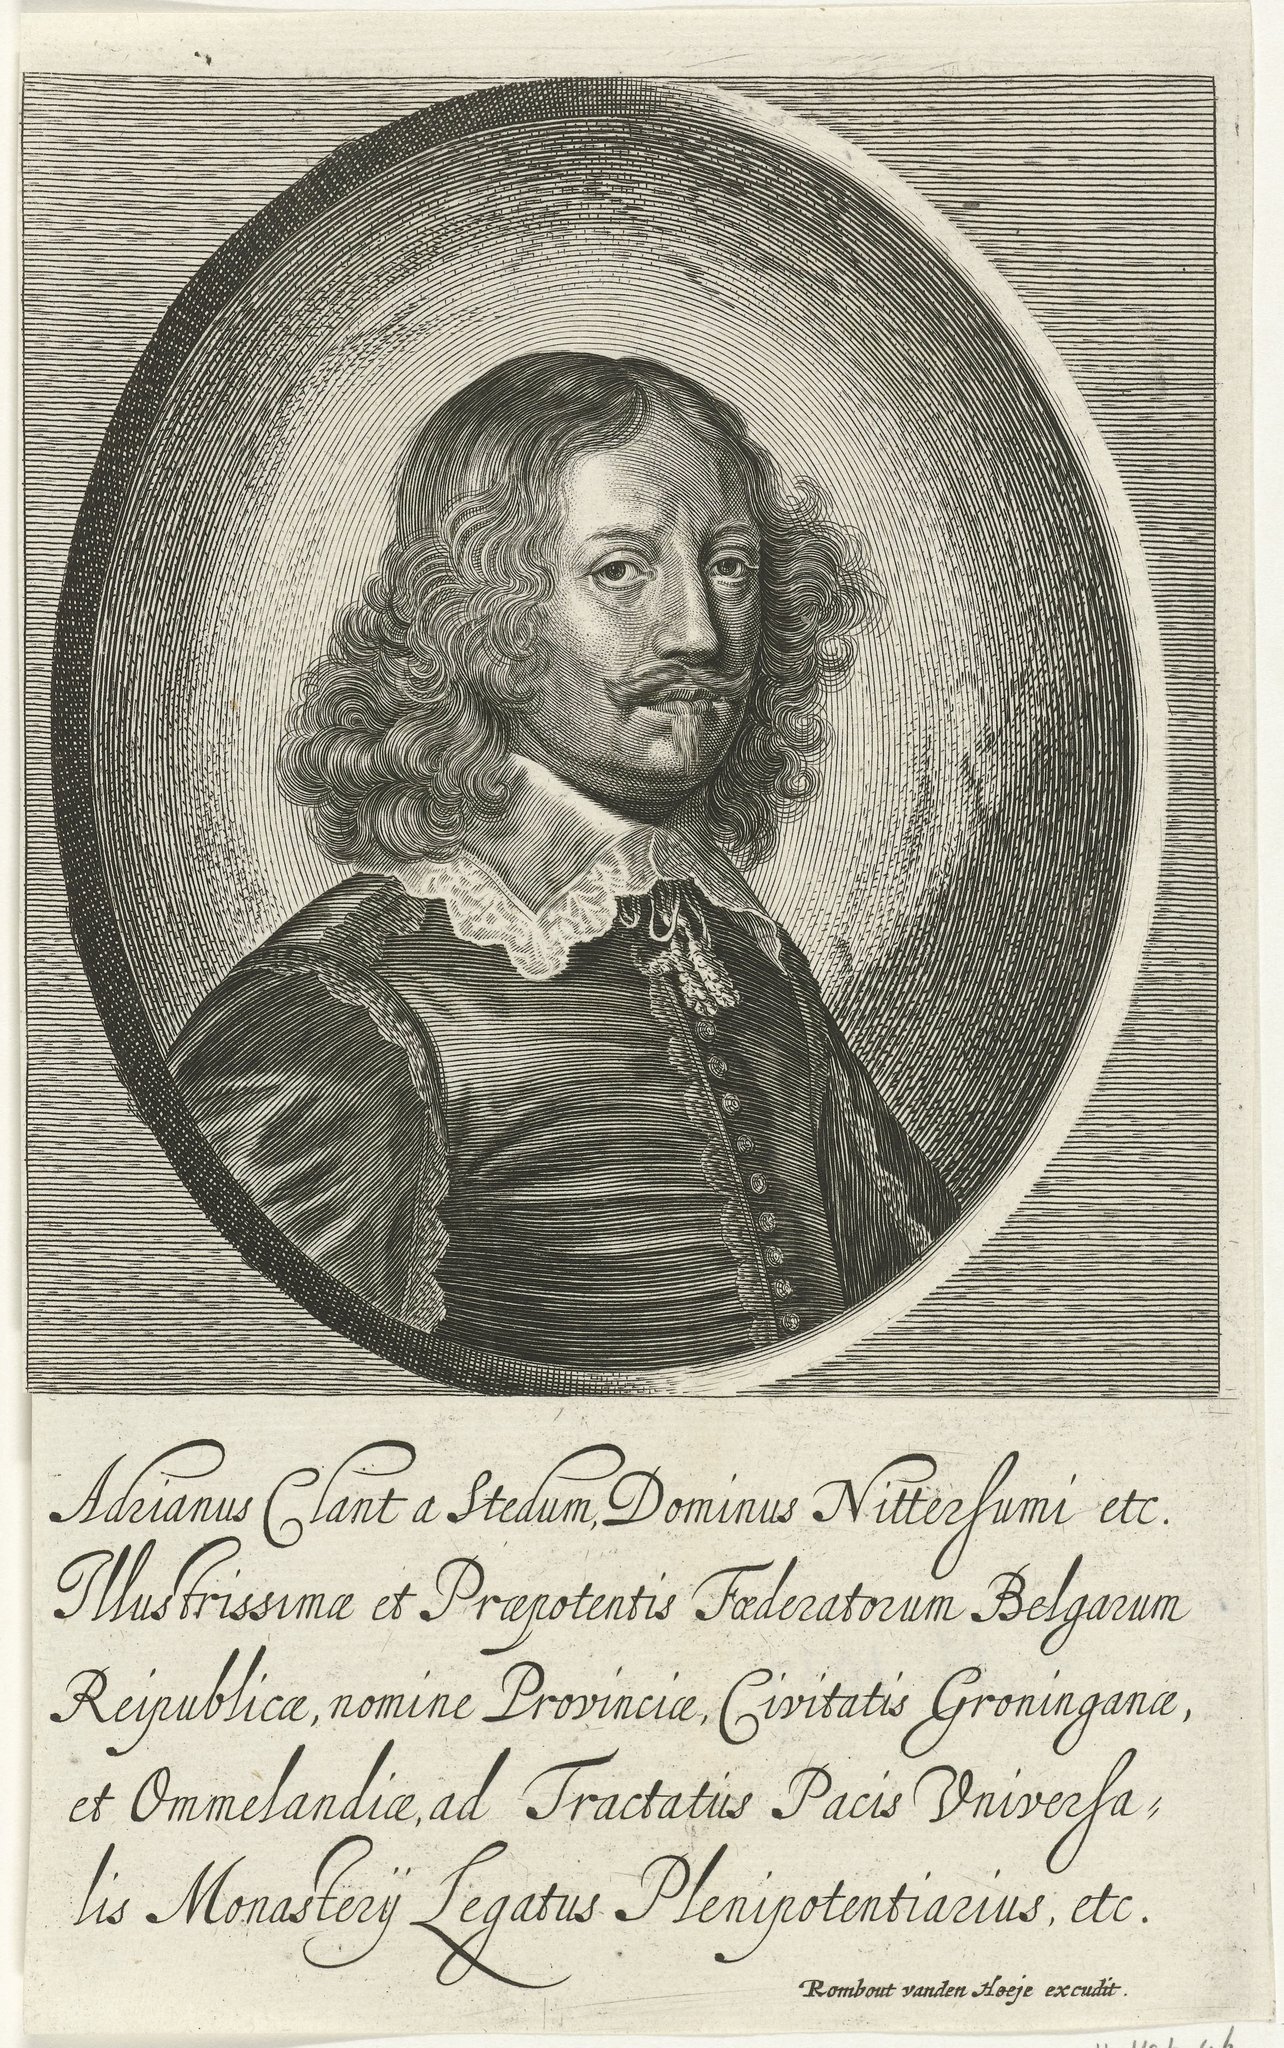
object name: print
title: Portretten van ambassadeurs van de Vrede van Munster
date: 1648-1670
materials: paper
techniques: engraving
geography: amsterdam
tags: diplomaat, adriaen clant, vrede van münster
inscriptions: collector's mark: Lugt 2228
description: Buste naar rechts van Adriaen Clant in een ovaal. Onder het portret vijf regels in het Latijn. Prent uit een serie portretten van ambassadeurs betrokken bij het vredesverdrag van Munster.